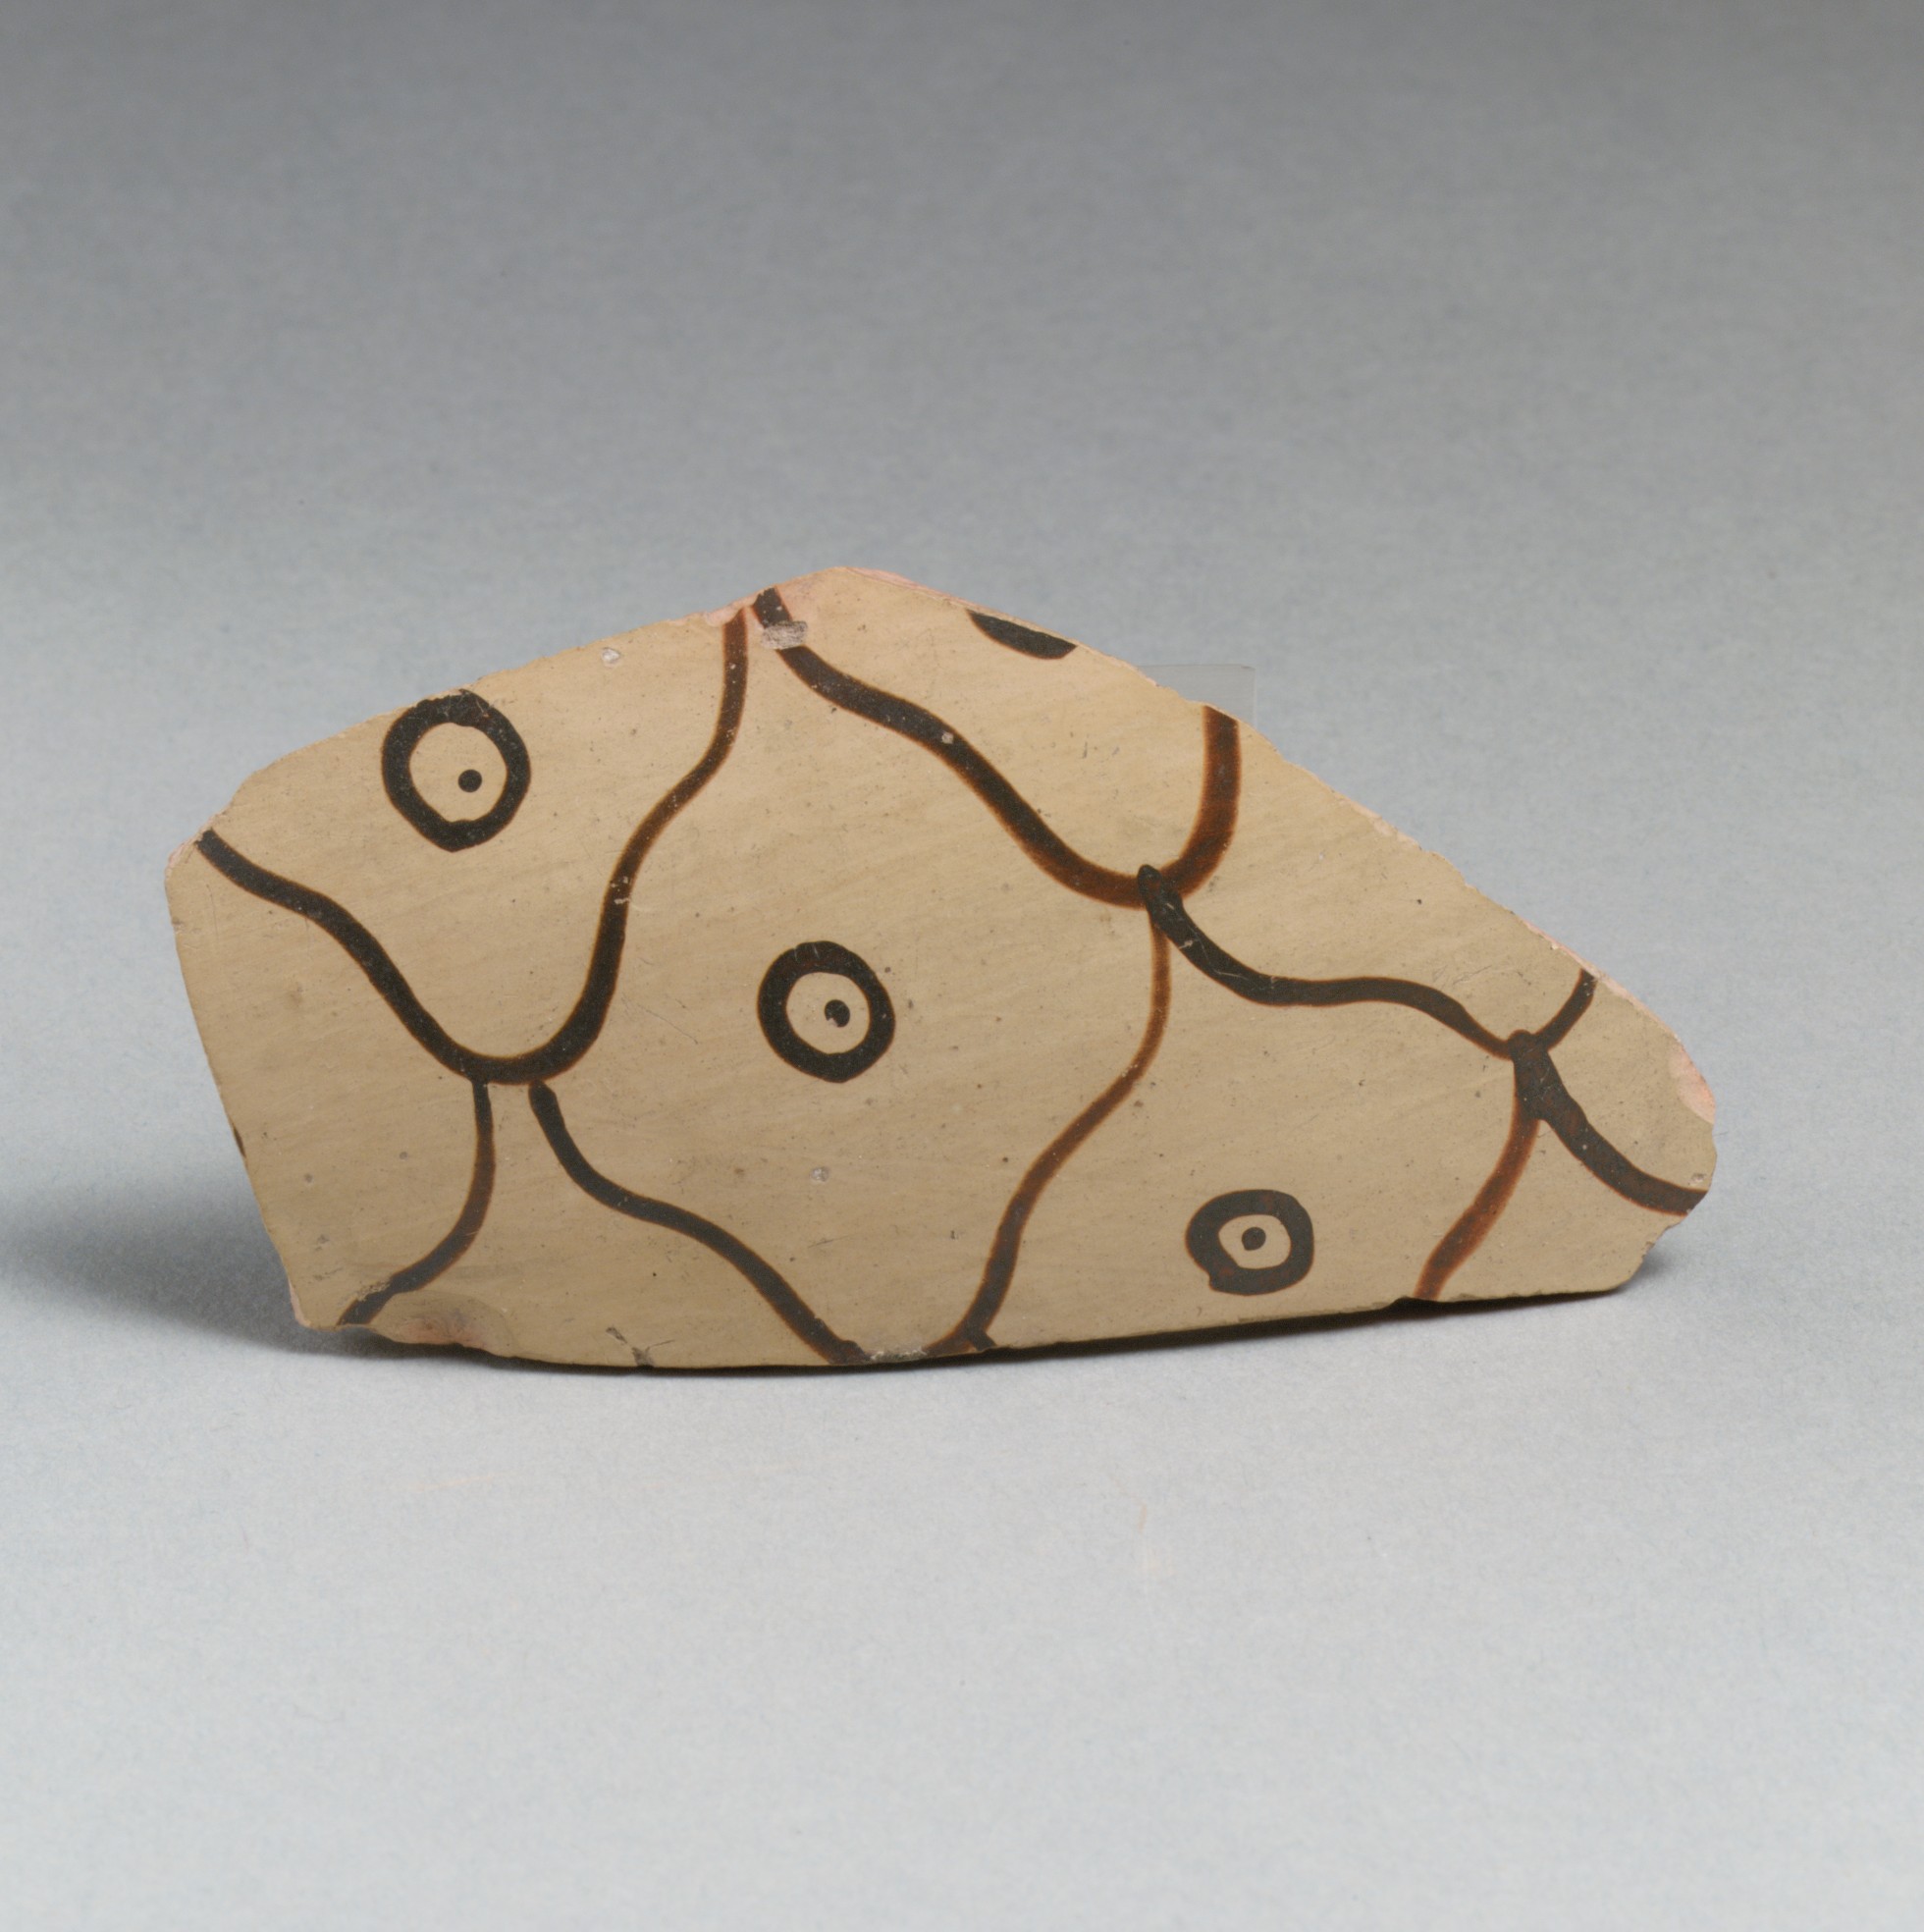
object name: vase fragment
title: Terracotta vessel fragment with net pattern and dots within circles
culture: mycenaean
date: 1400 BCE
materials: terracotta